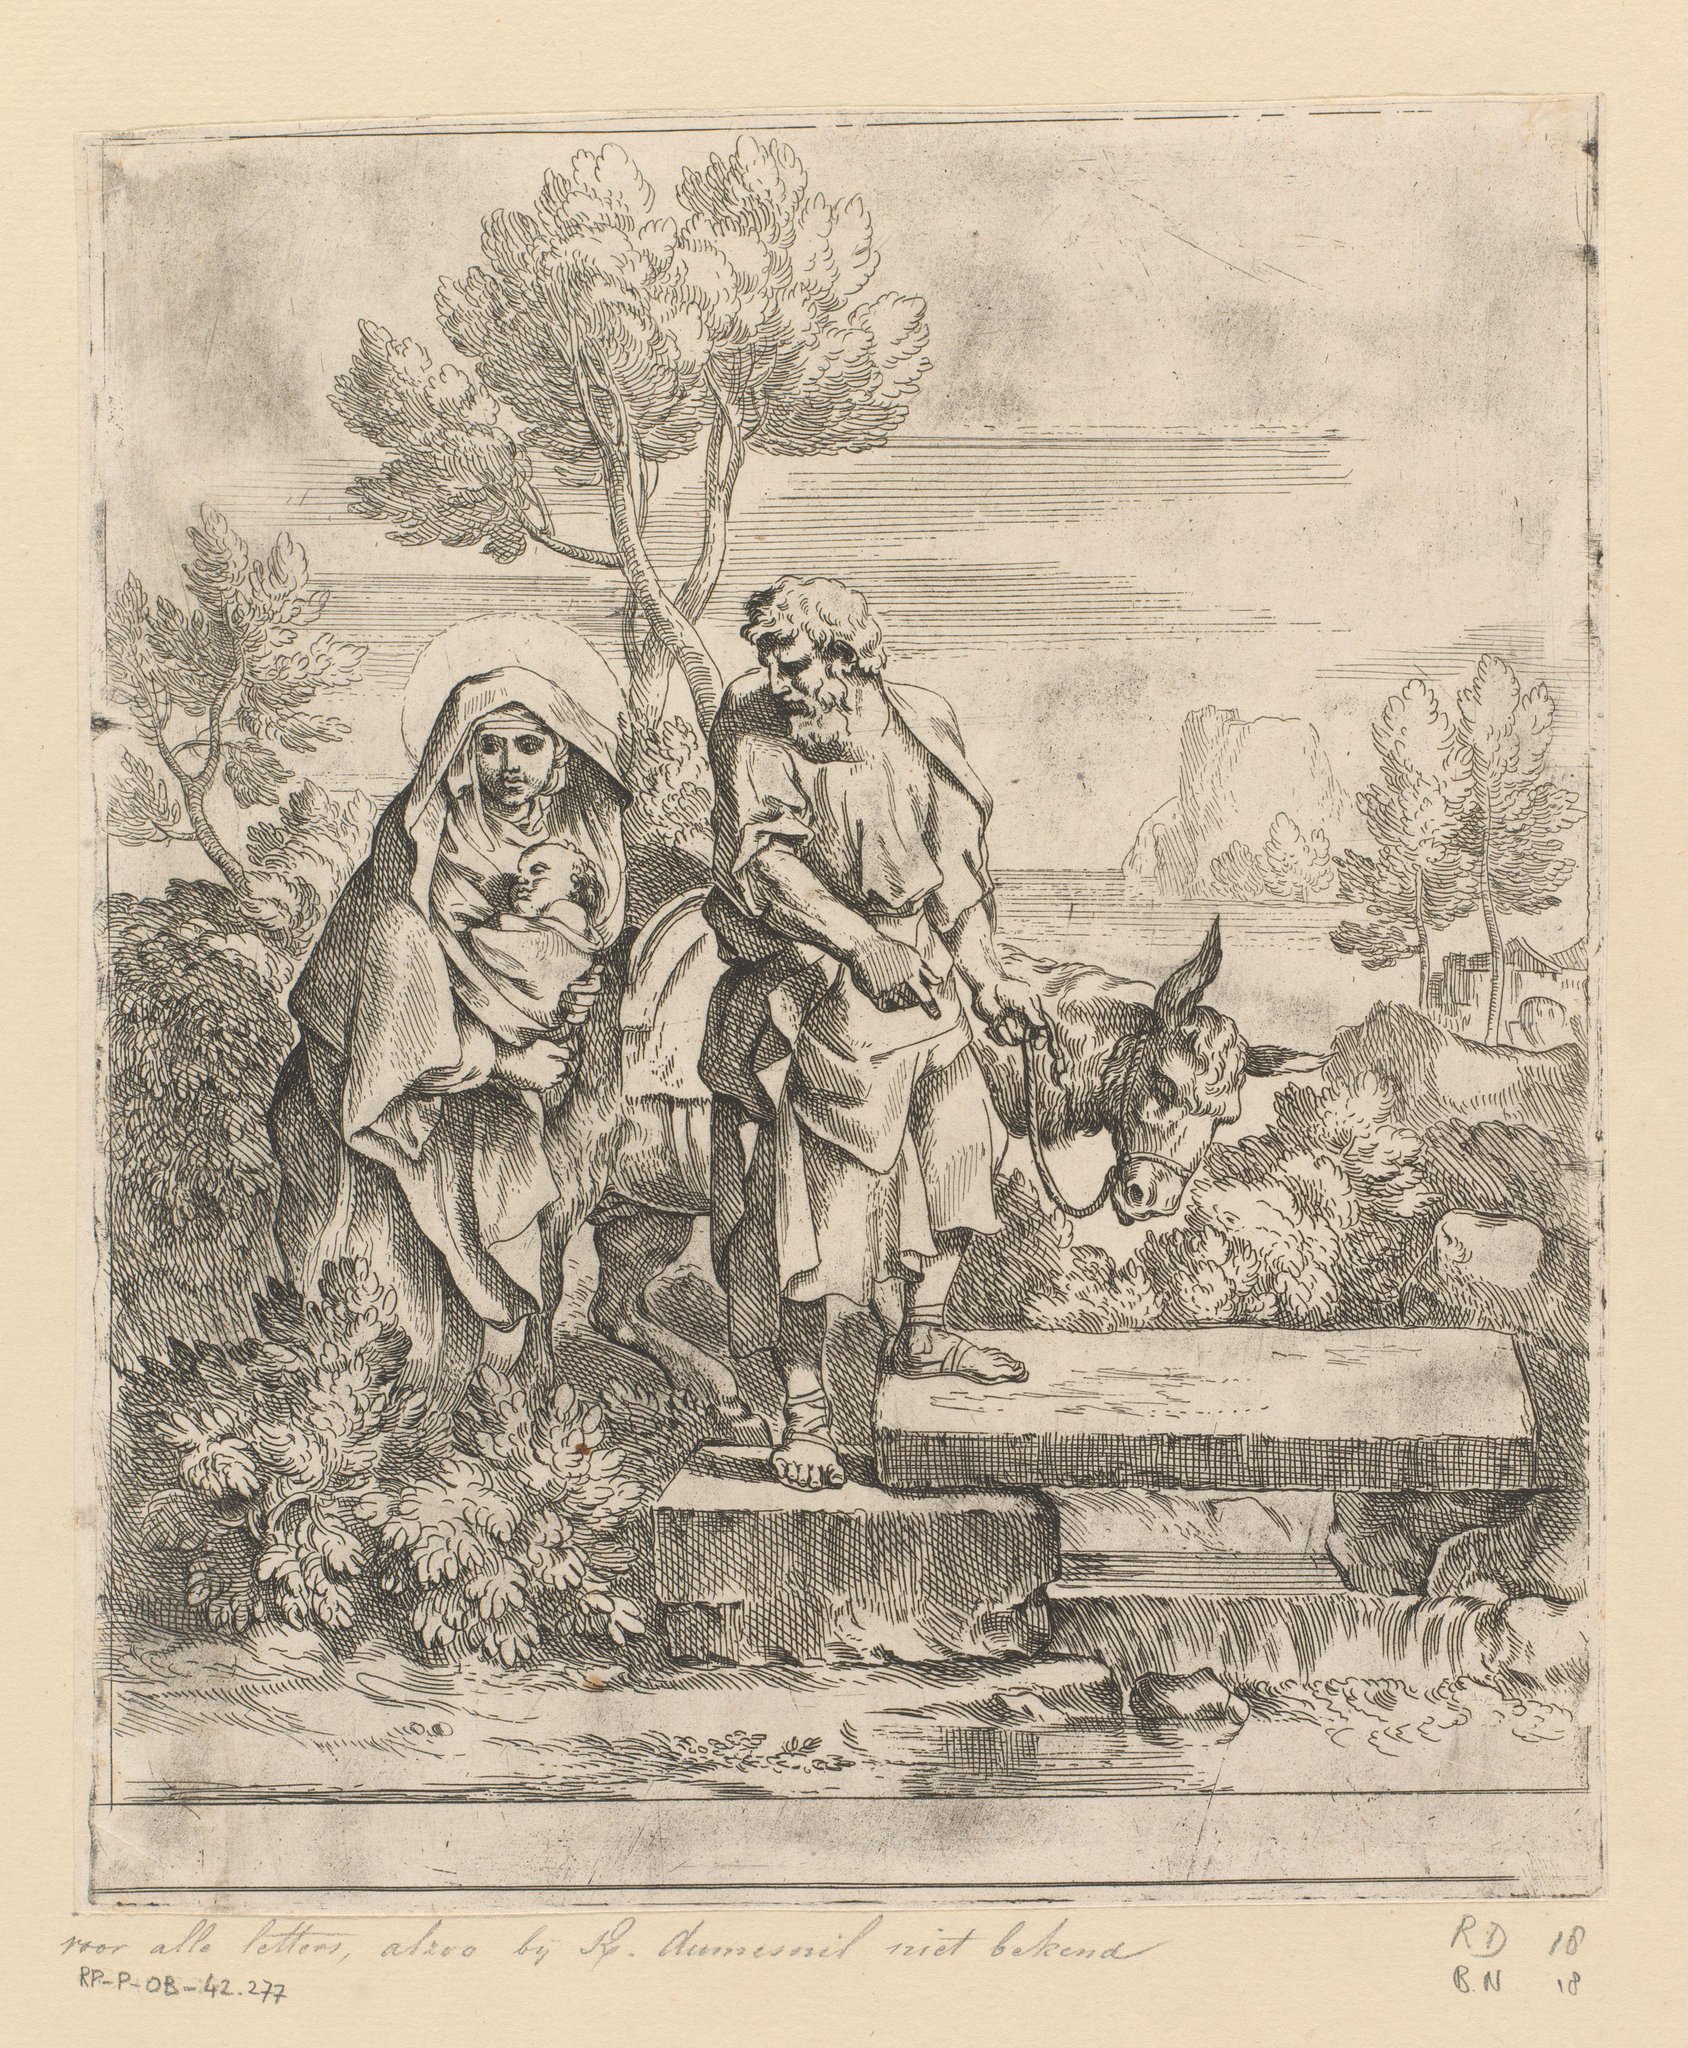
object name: print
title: Vlucht naar Egypte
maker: sébastien bourdon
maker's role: draughtsman, painter, print maker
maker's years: 1616-1671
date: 1626-1671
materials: paper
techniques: etching, intaglio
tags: the flight into egypt: mary, joseph, the child (and sometimes others) on their way; mary usually riding on an ass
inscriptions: collector's mark: Lugt 240